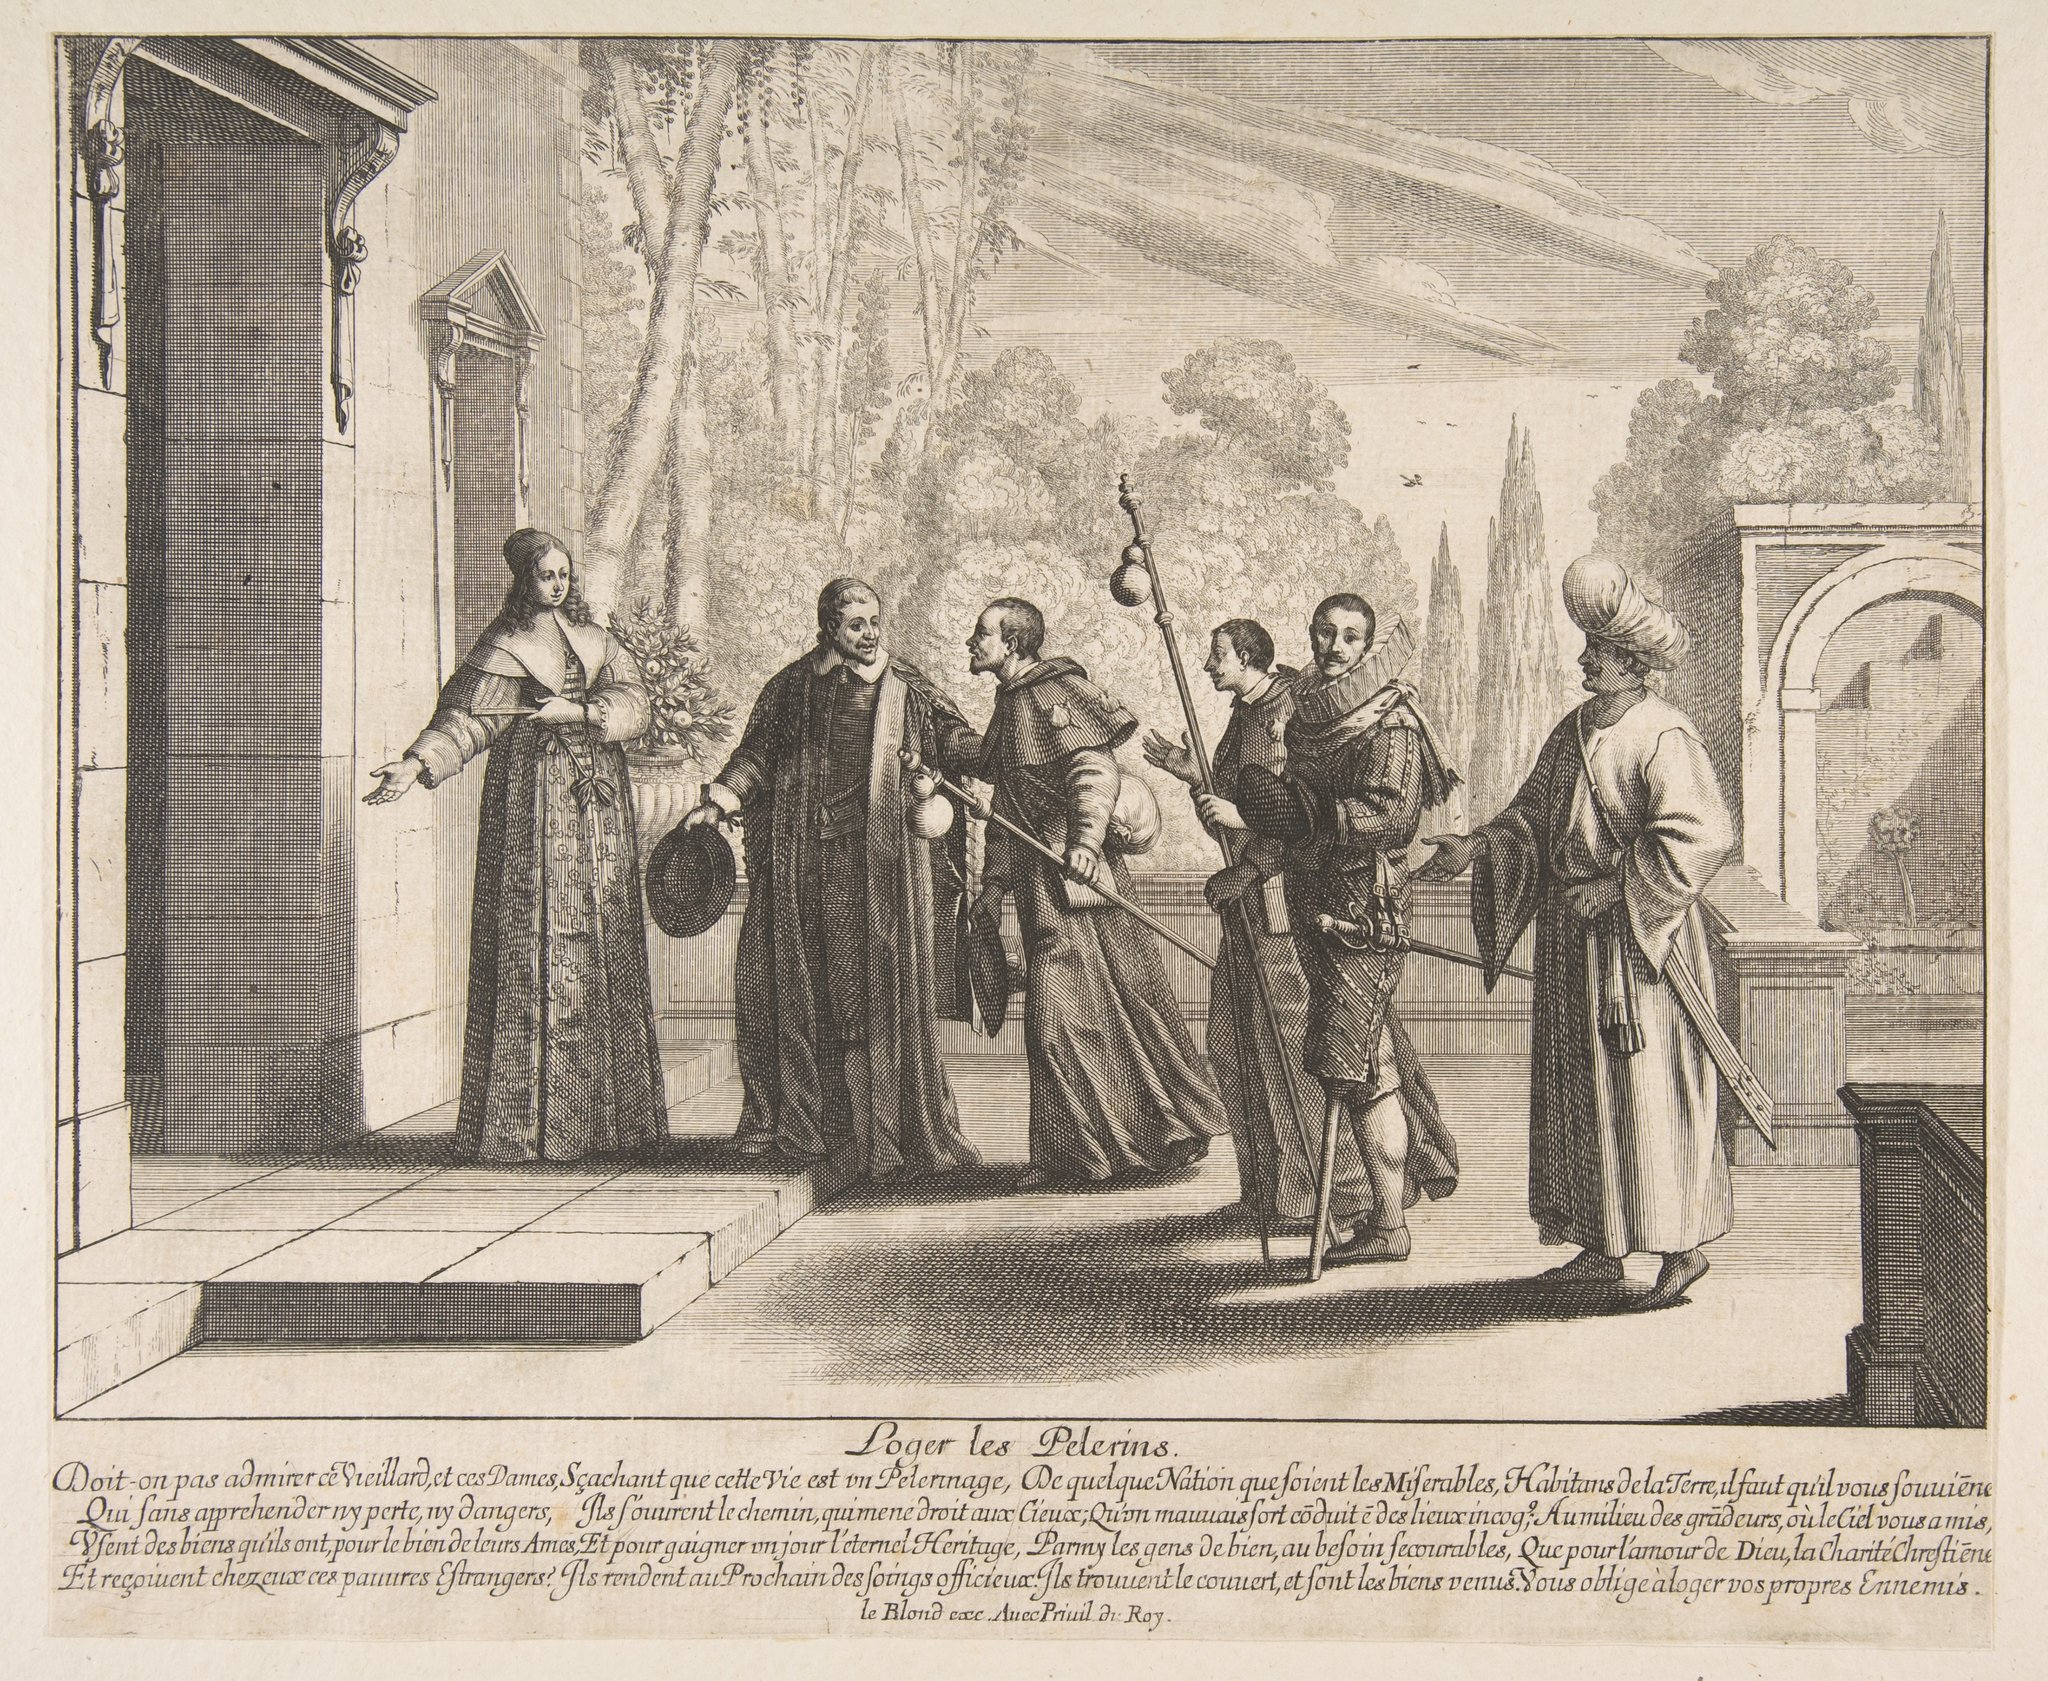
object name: print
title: Lodging Pilgrims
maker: abraham bosse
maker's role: artist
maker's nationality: french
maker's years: 1602-1676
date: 1635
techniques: engraving, etching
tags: men,women